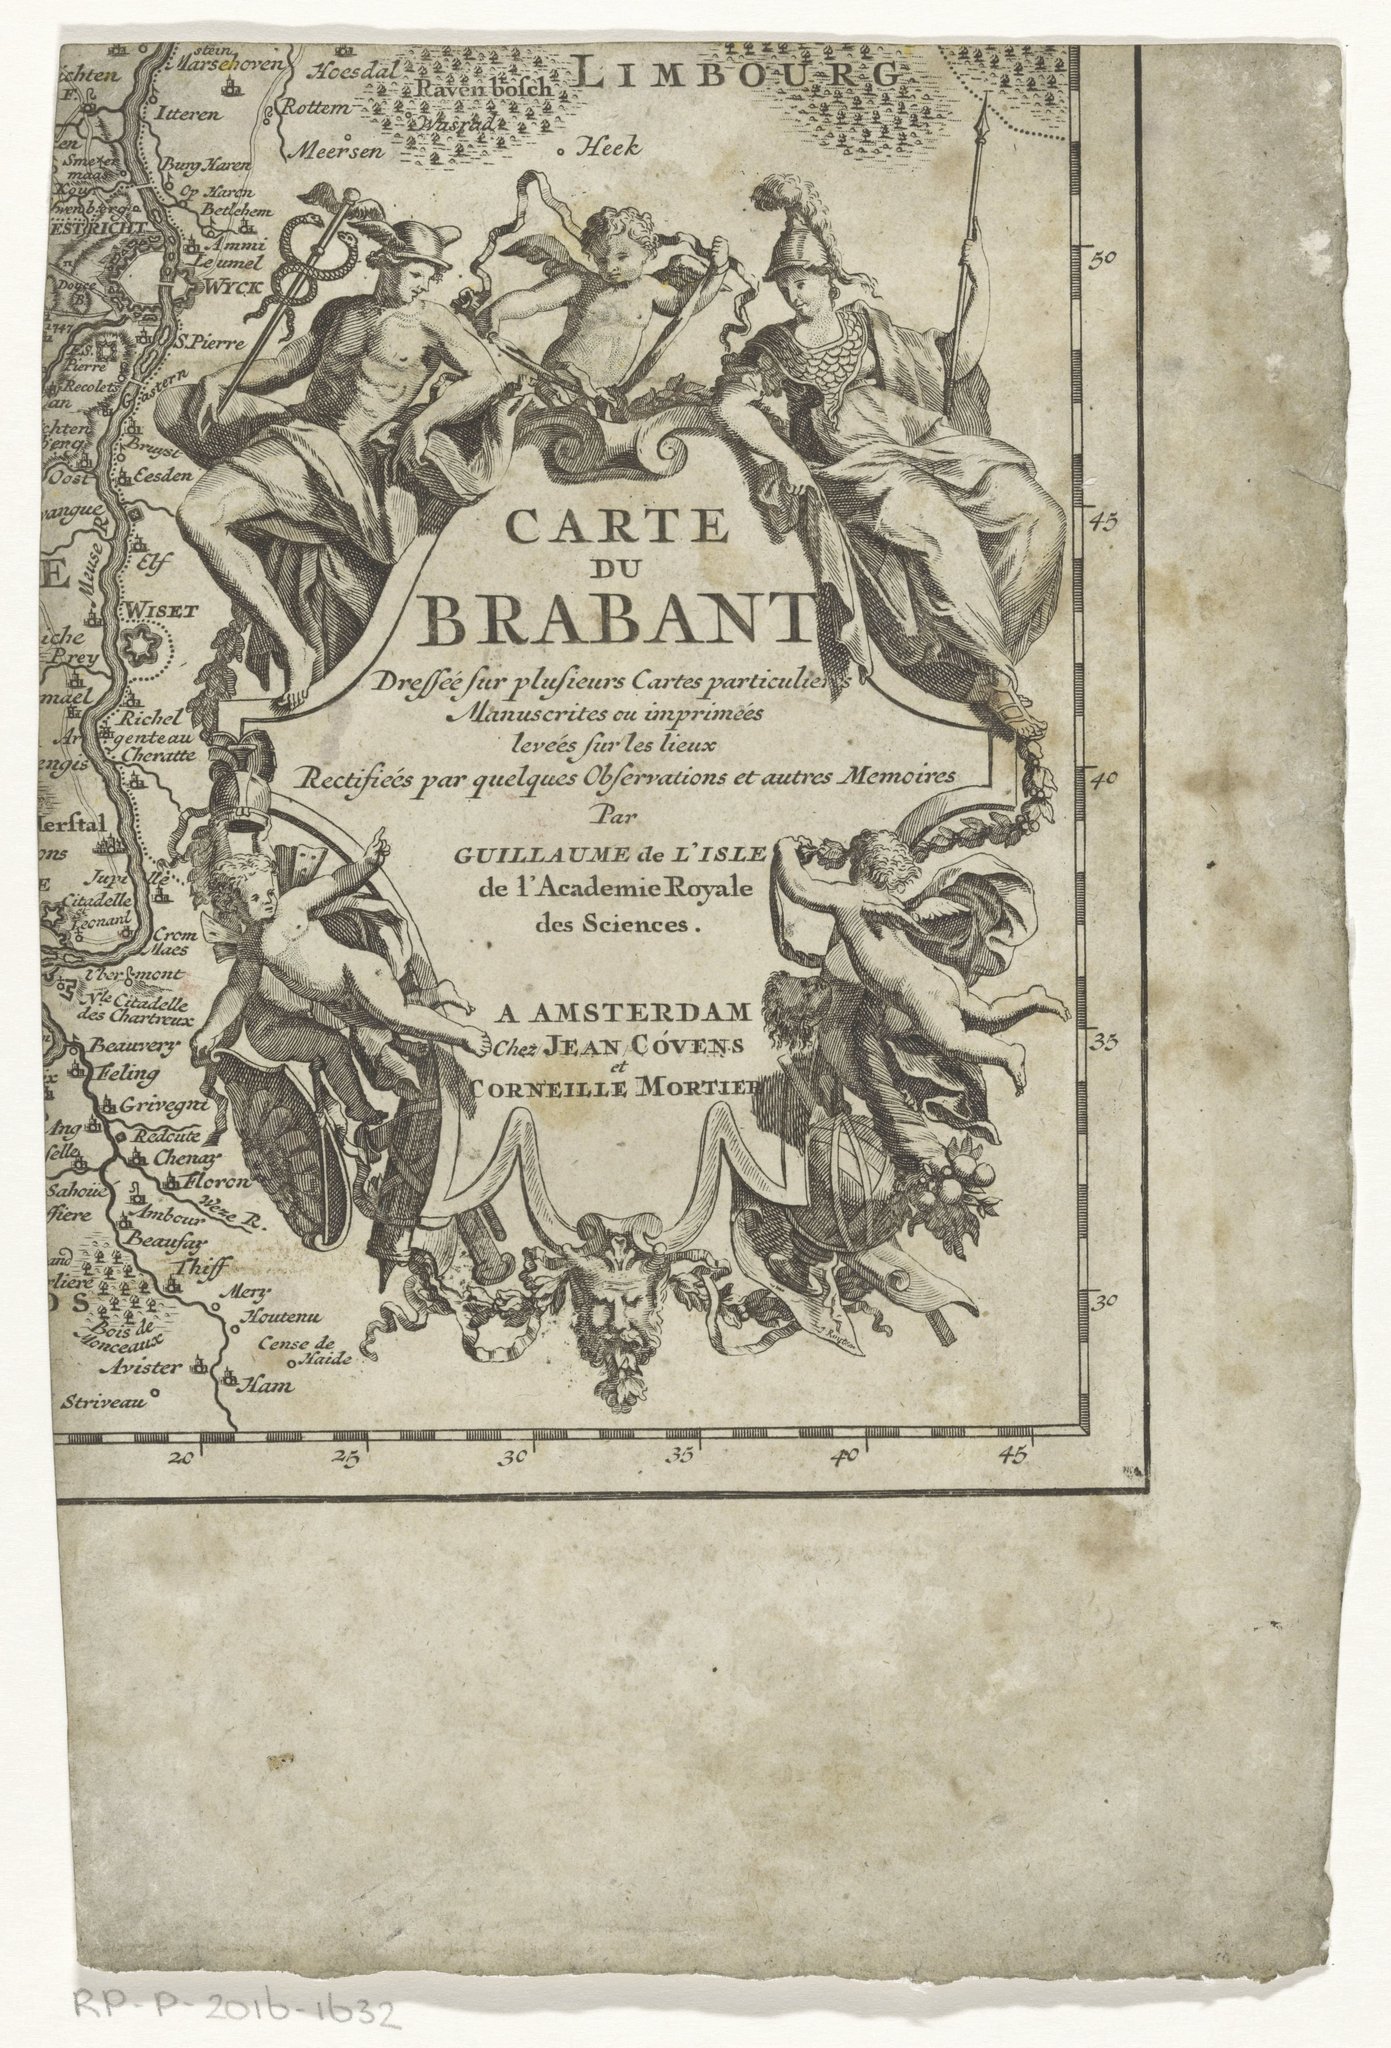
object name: print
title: Mercurius, Minerva en putti bij cartouche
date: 1721-1774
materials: paper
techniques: engraving, etching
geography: amsterdam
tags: (story of) minerva (pallas, athena), (story of) mercury (hermes), ornament ~ cartouche, cupids: 'amores', 'amoretti', 'putti', brabant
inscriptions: collector's mark: Lugt 2228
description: Een cartouche met titel wordt versierd door drie putti. Mercurius met caduceus en Minerva met lans kijken vanaf de bovenzijde toe. Aan de onderzijde hangen wapens, papieren en een globe. Detail van een kaart van Brabant.